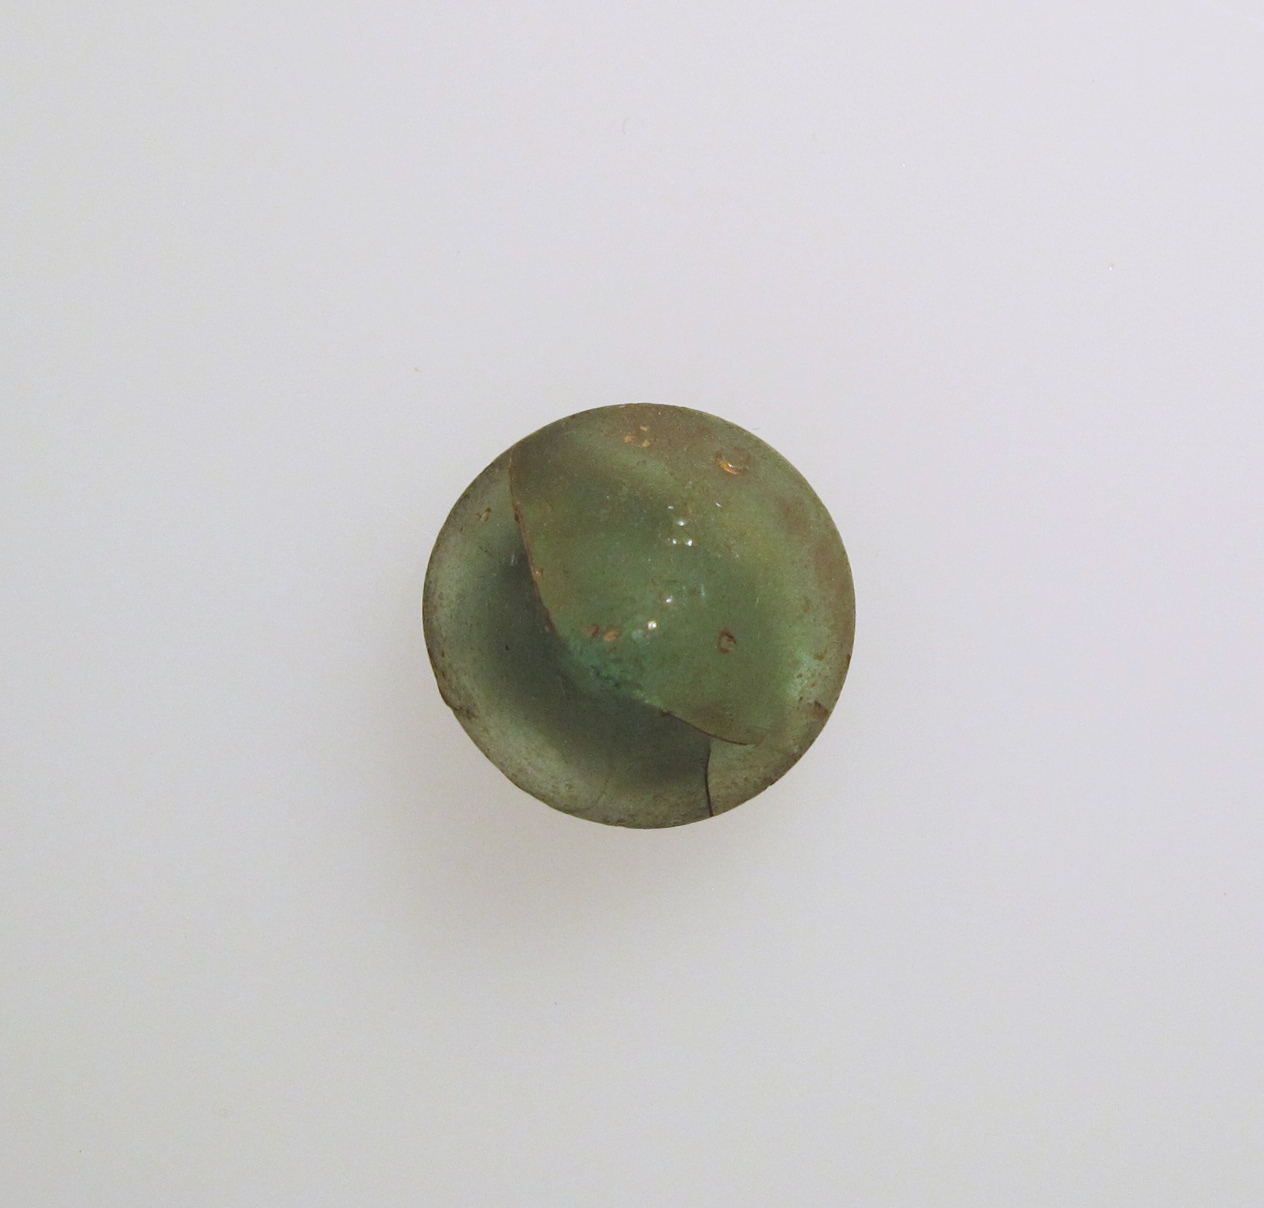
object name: ornament cone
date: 7000 BCE-330 CE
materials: glass